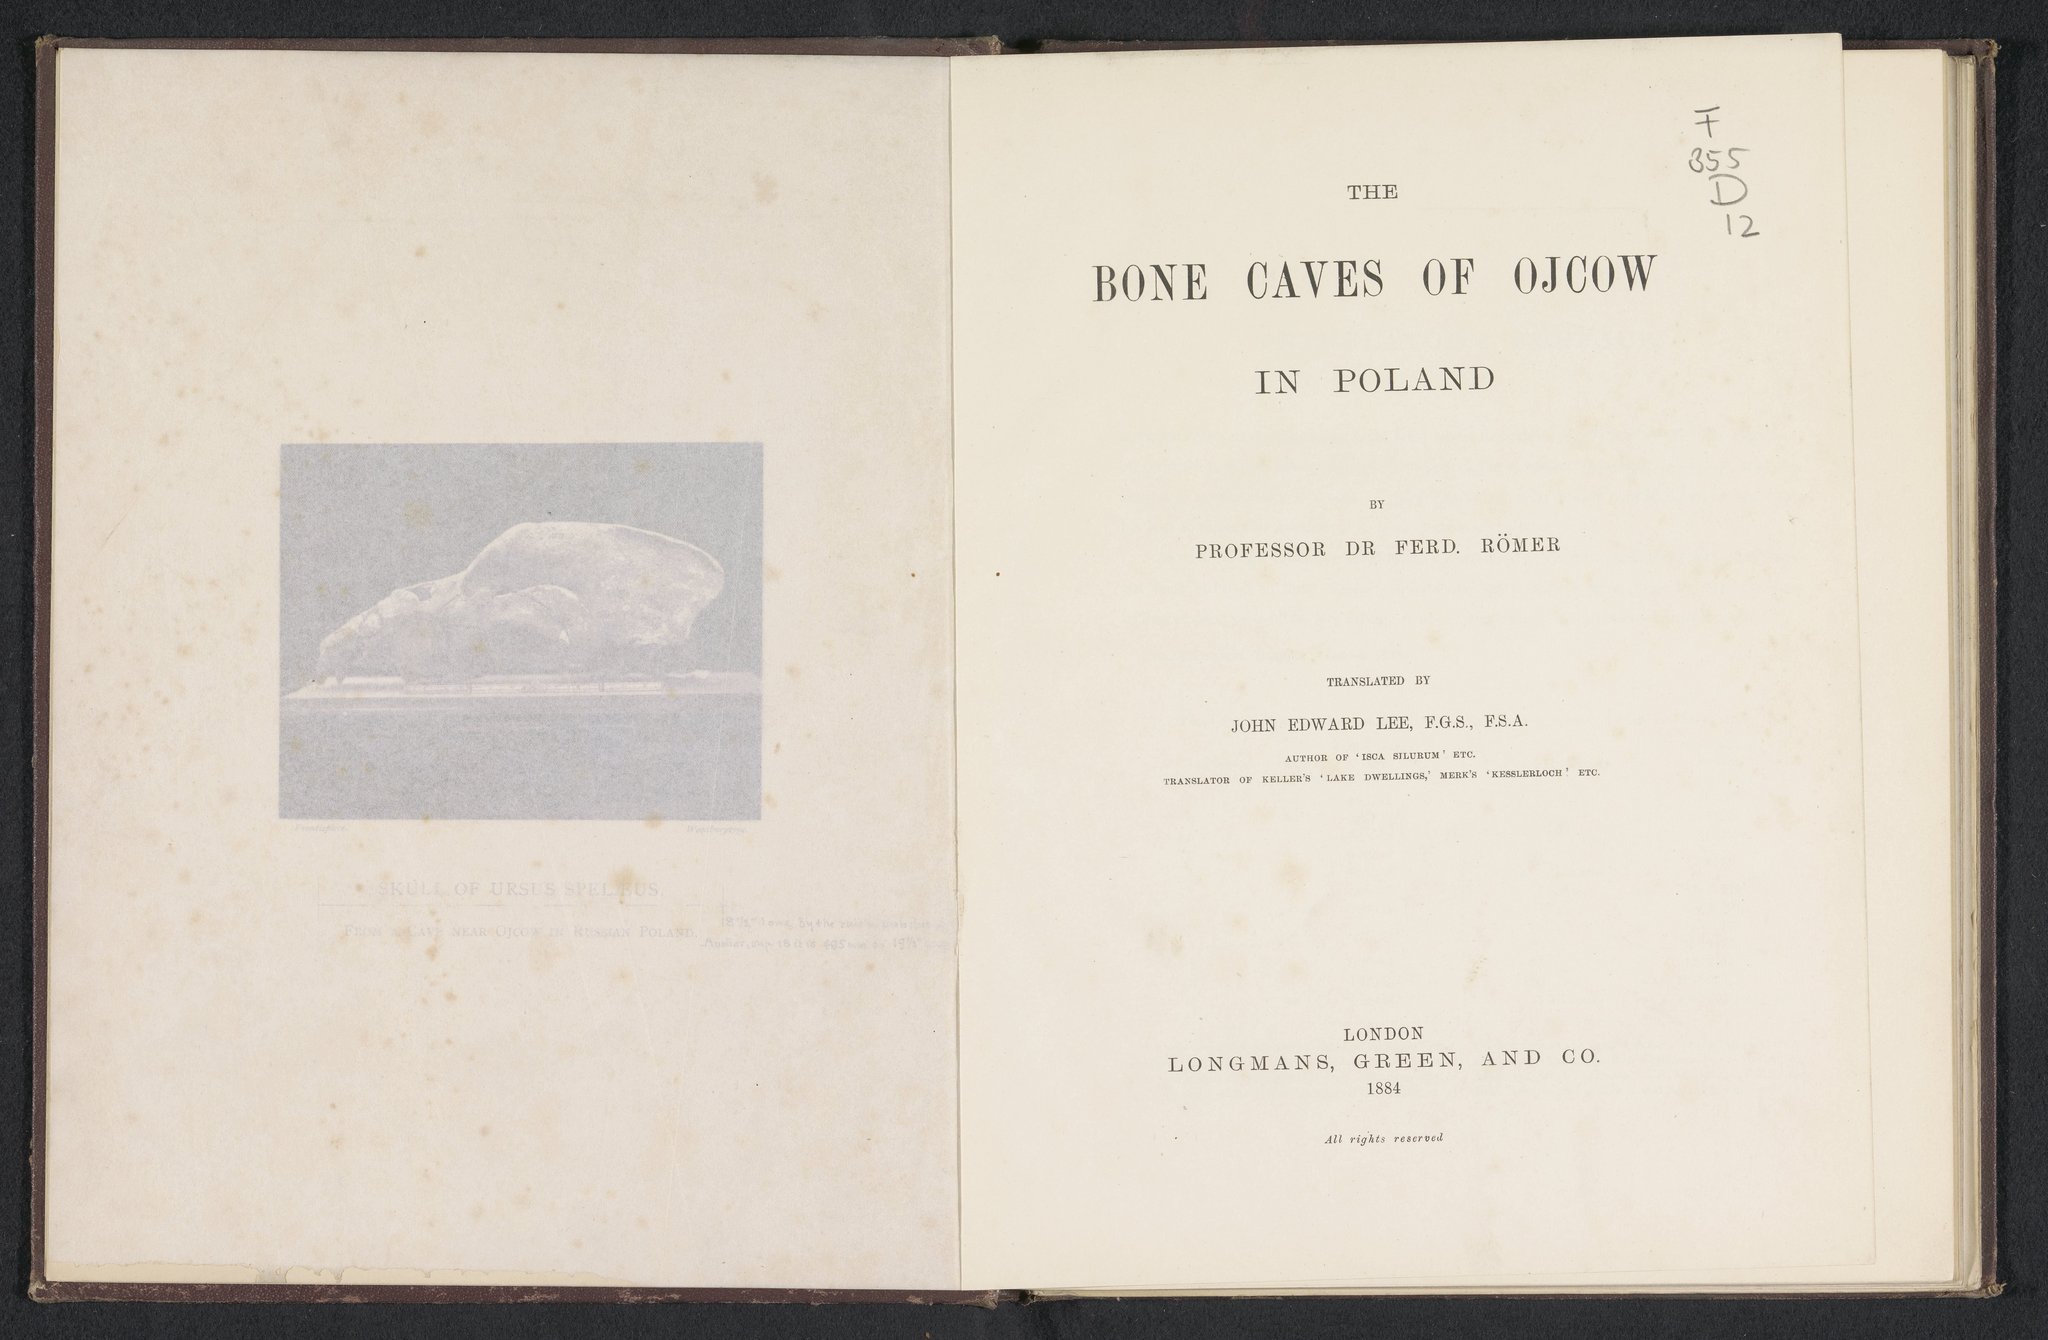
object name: book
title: The bone caves of Ojcow in Poland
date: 1884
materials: cardboard, linen, paper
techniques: lithograph, woodburytype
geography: london